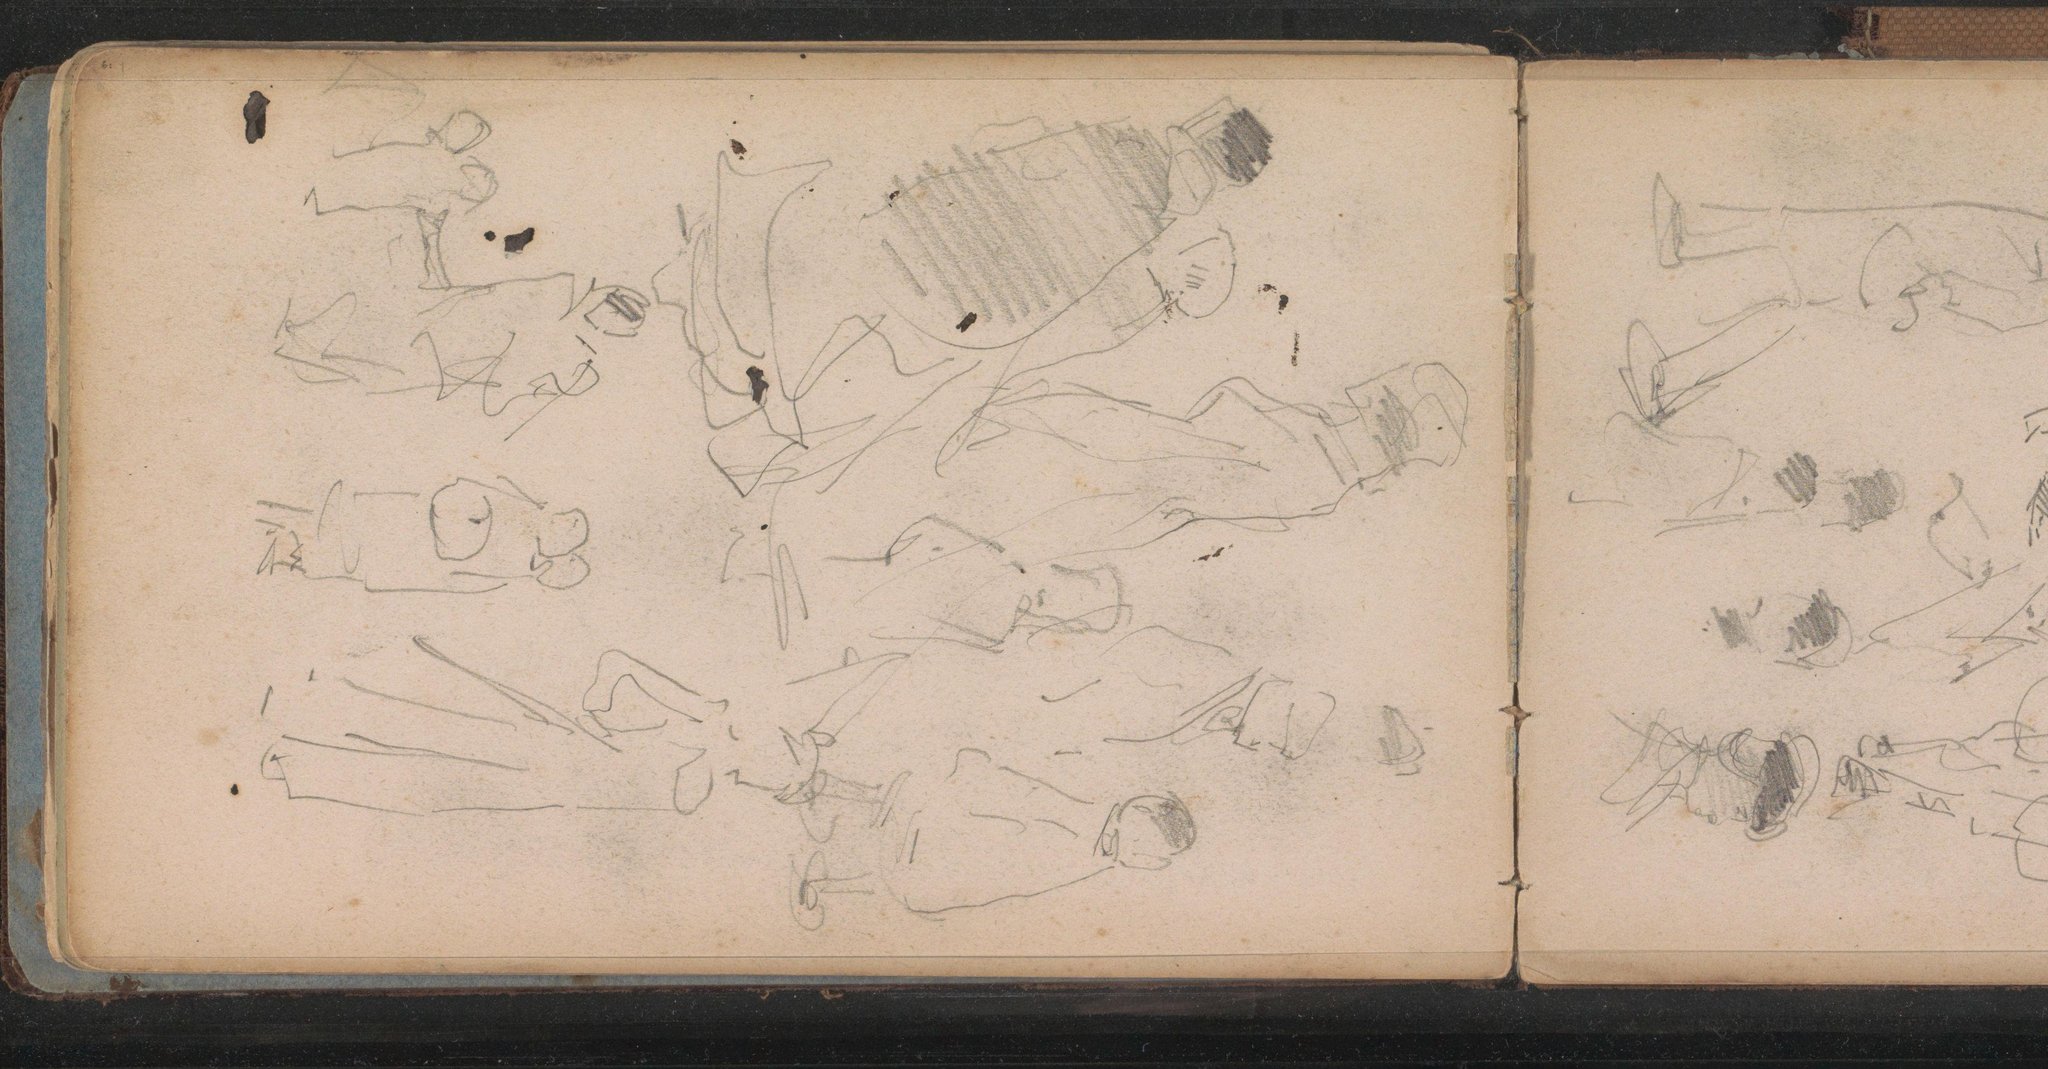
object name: sketchbook leaf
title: Figuurstudies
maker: george hendrik breitner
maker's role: draughtsman, painter, print maker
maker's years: 1857-1923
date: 1880-1882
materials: paper, pencil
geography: scheveningen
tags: adult woman, adult man, child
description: Pagina 61 uit een schetsboek met 37 bladen.